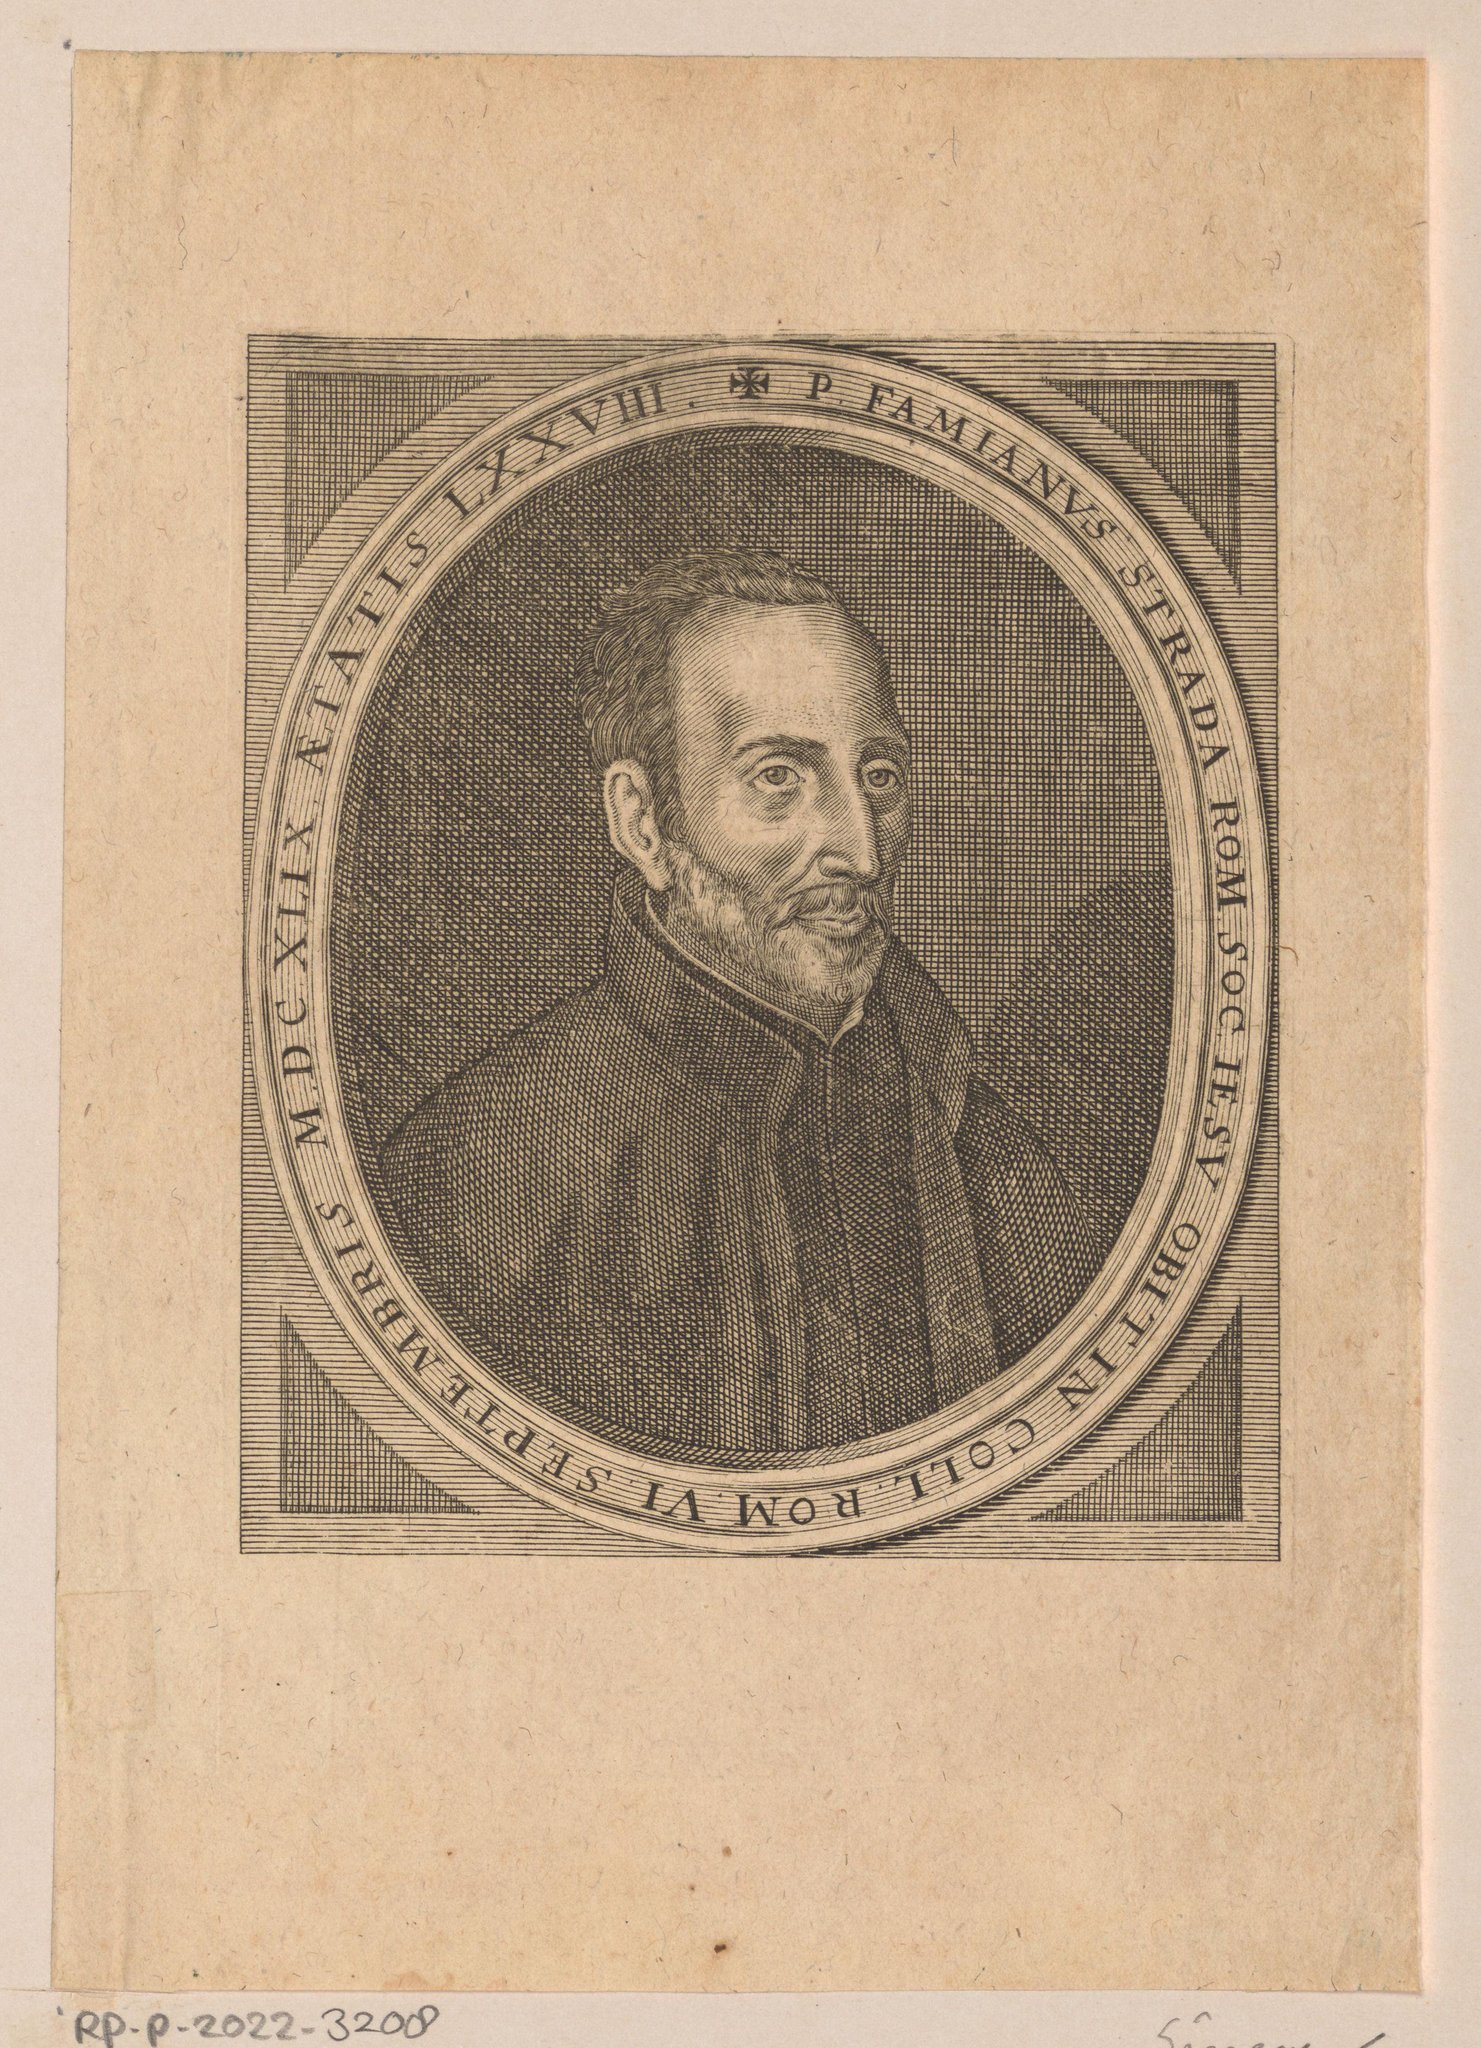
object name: print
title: Portret van Famiano Strada op 78-jarige leeftijd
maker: Anonymous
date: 1649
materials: paper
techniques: engraving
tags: rome, history and archaeology (+ portrait of scholar, scientist), historical persons, portrait of a writer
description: Met tekst in het Latijn rondom het portret.